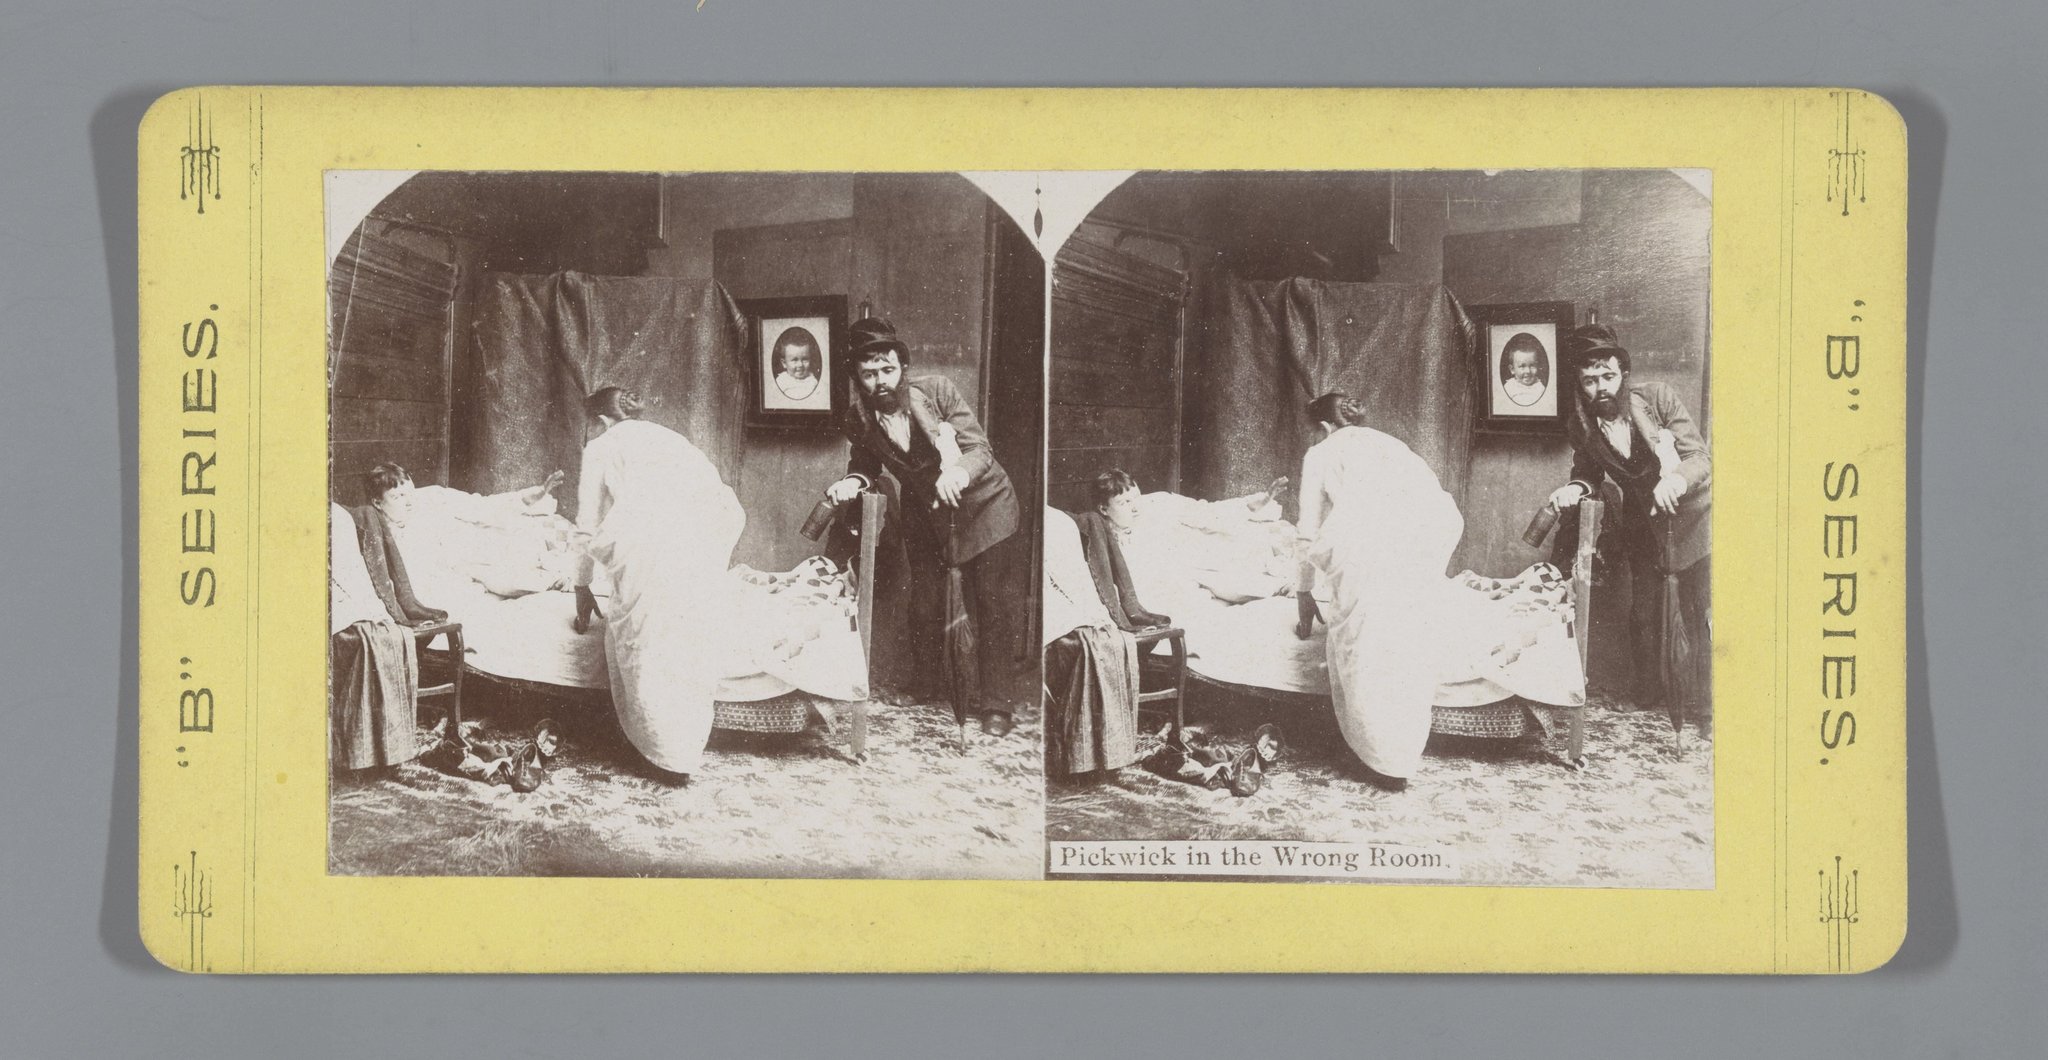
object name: stereograph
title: Pickwick in the Wrong Room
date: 1880-1910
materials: cardboard, photographic support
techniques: gelatin silver print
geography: the hague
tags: bedroom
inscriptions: workshop stamp: ‘Appareils et Articles / pour la Photographie/ S. Bosman / Opticien / La Haye (Hollande)’